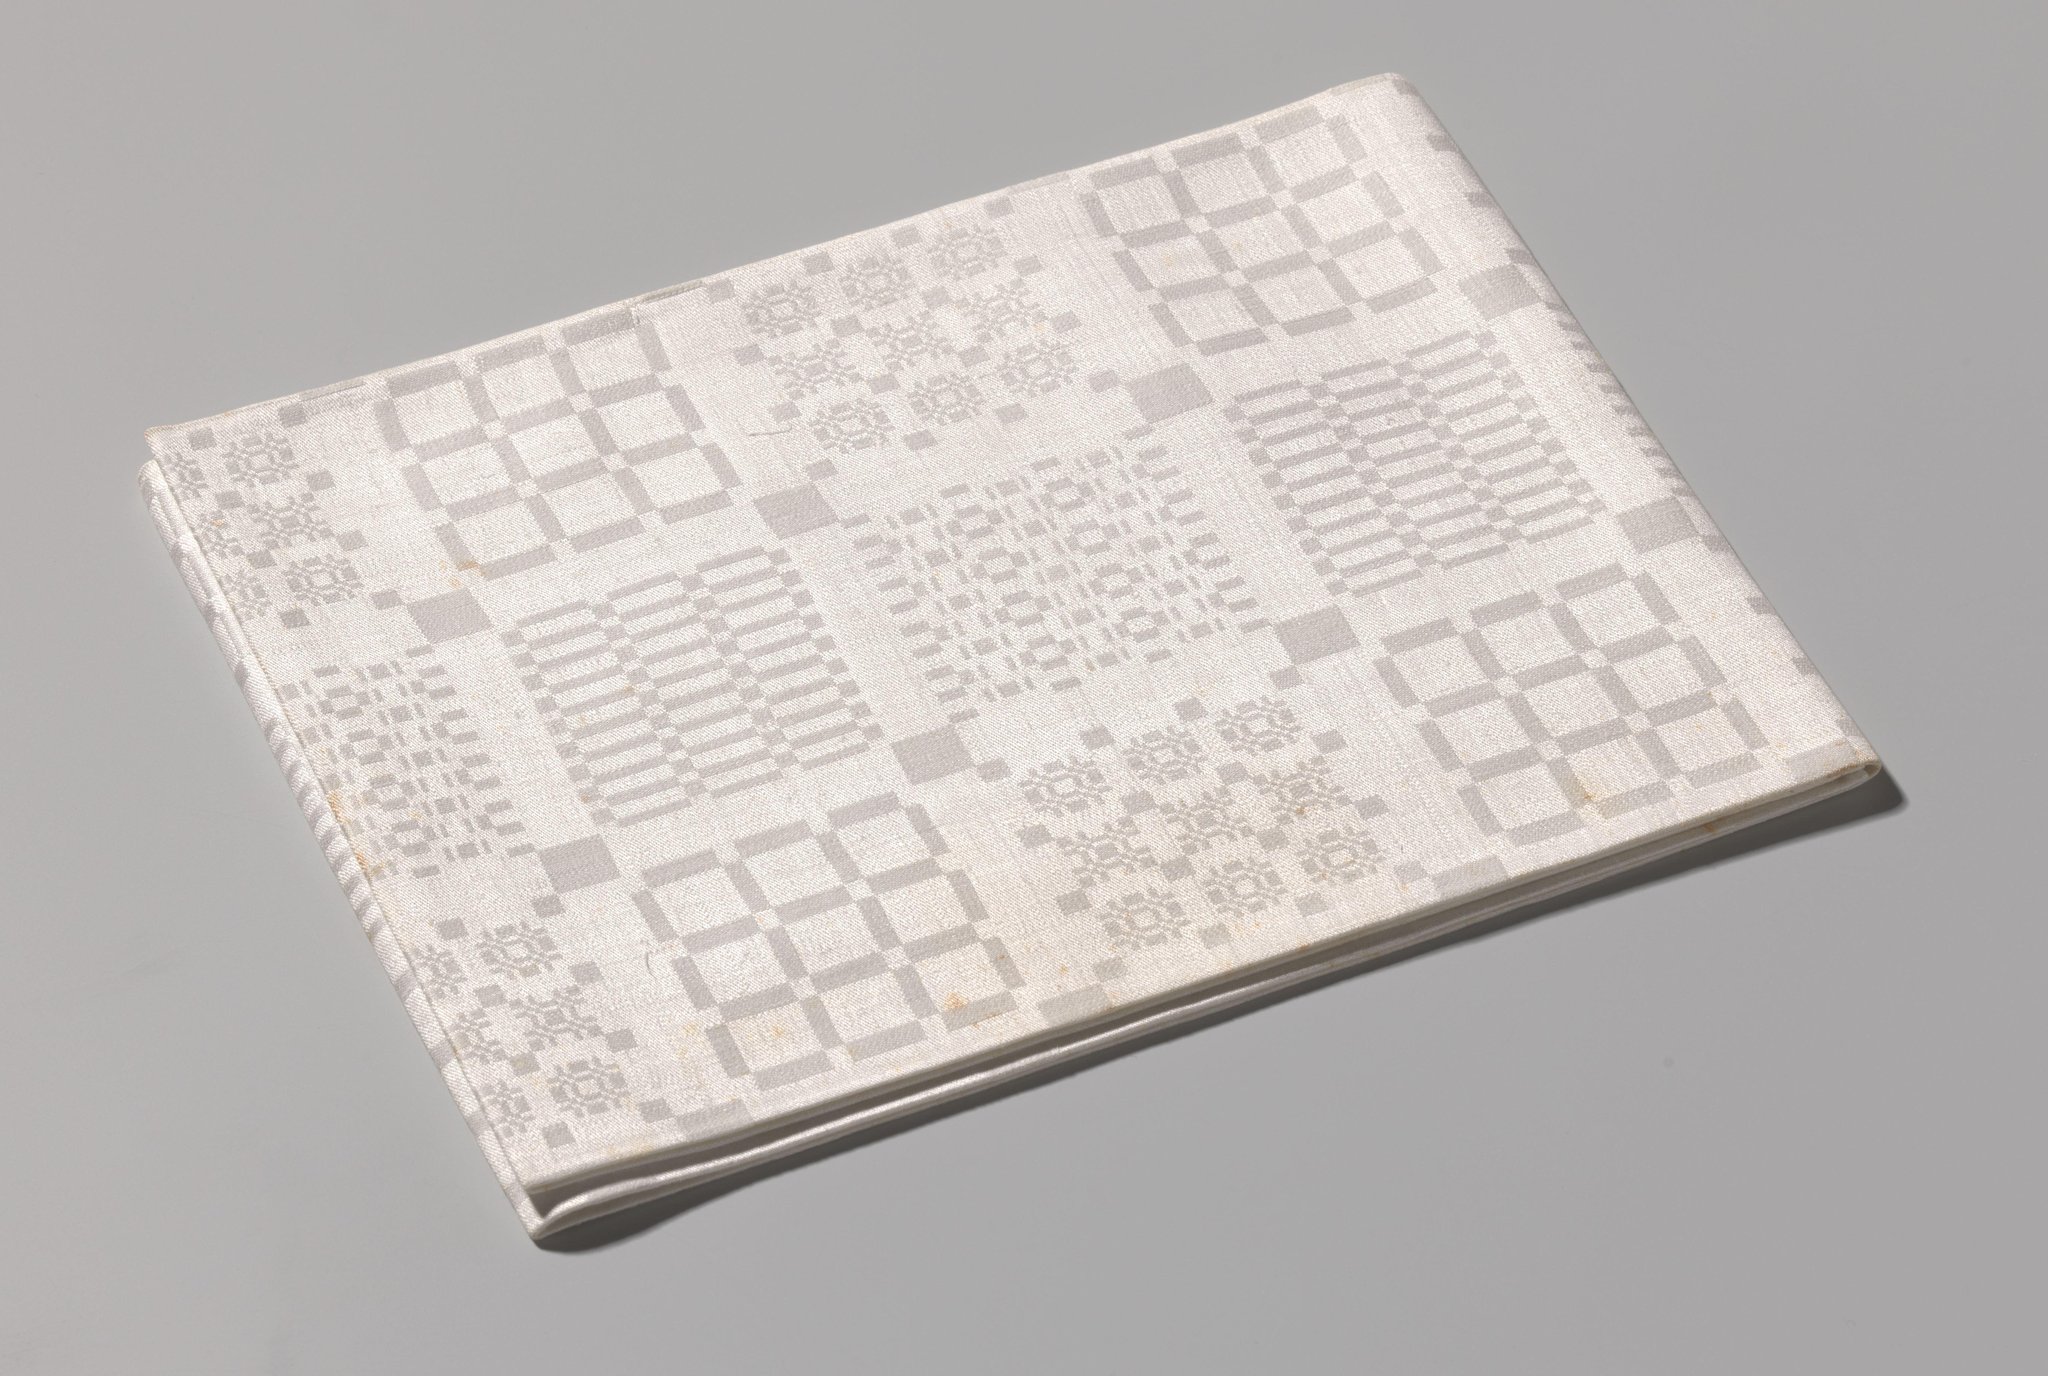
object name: napkin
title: Servet van linnen met pellenpatroon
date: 1737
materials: linen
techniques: peeled fabric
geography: northern netherlands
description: Wit linnen servet met pellenpatroon, genaamd "Oostindische caracters". Merk kroon WG 36 1737.